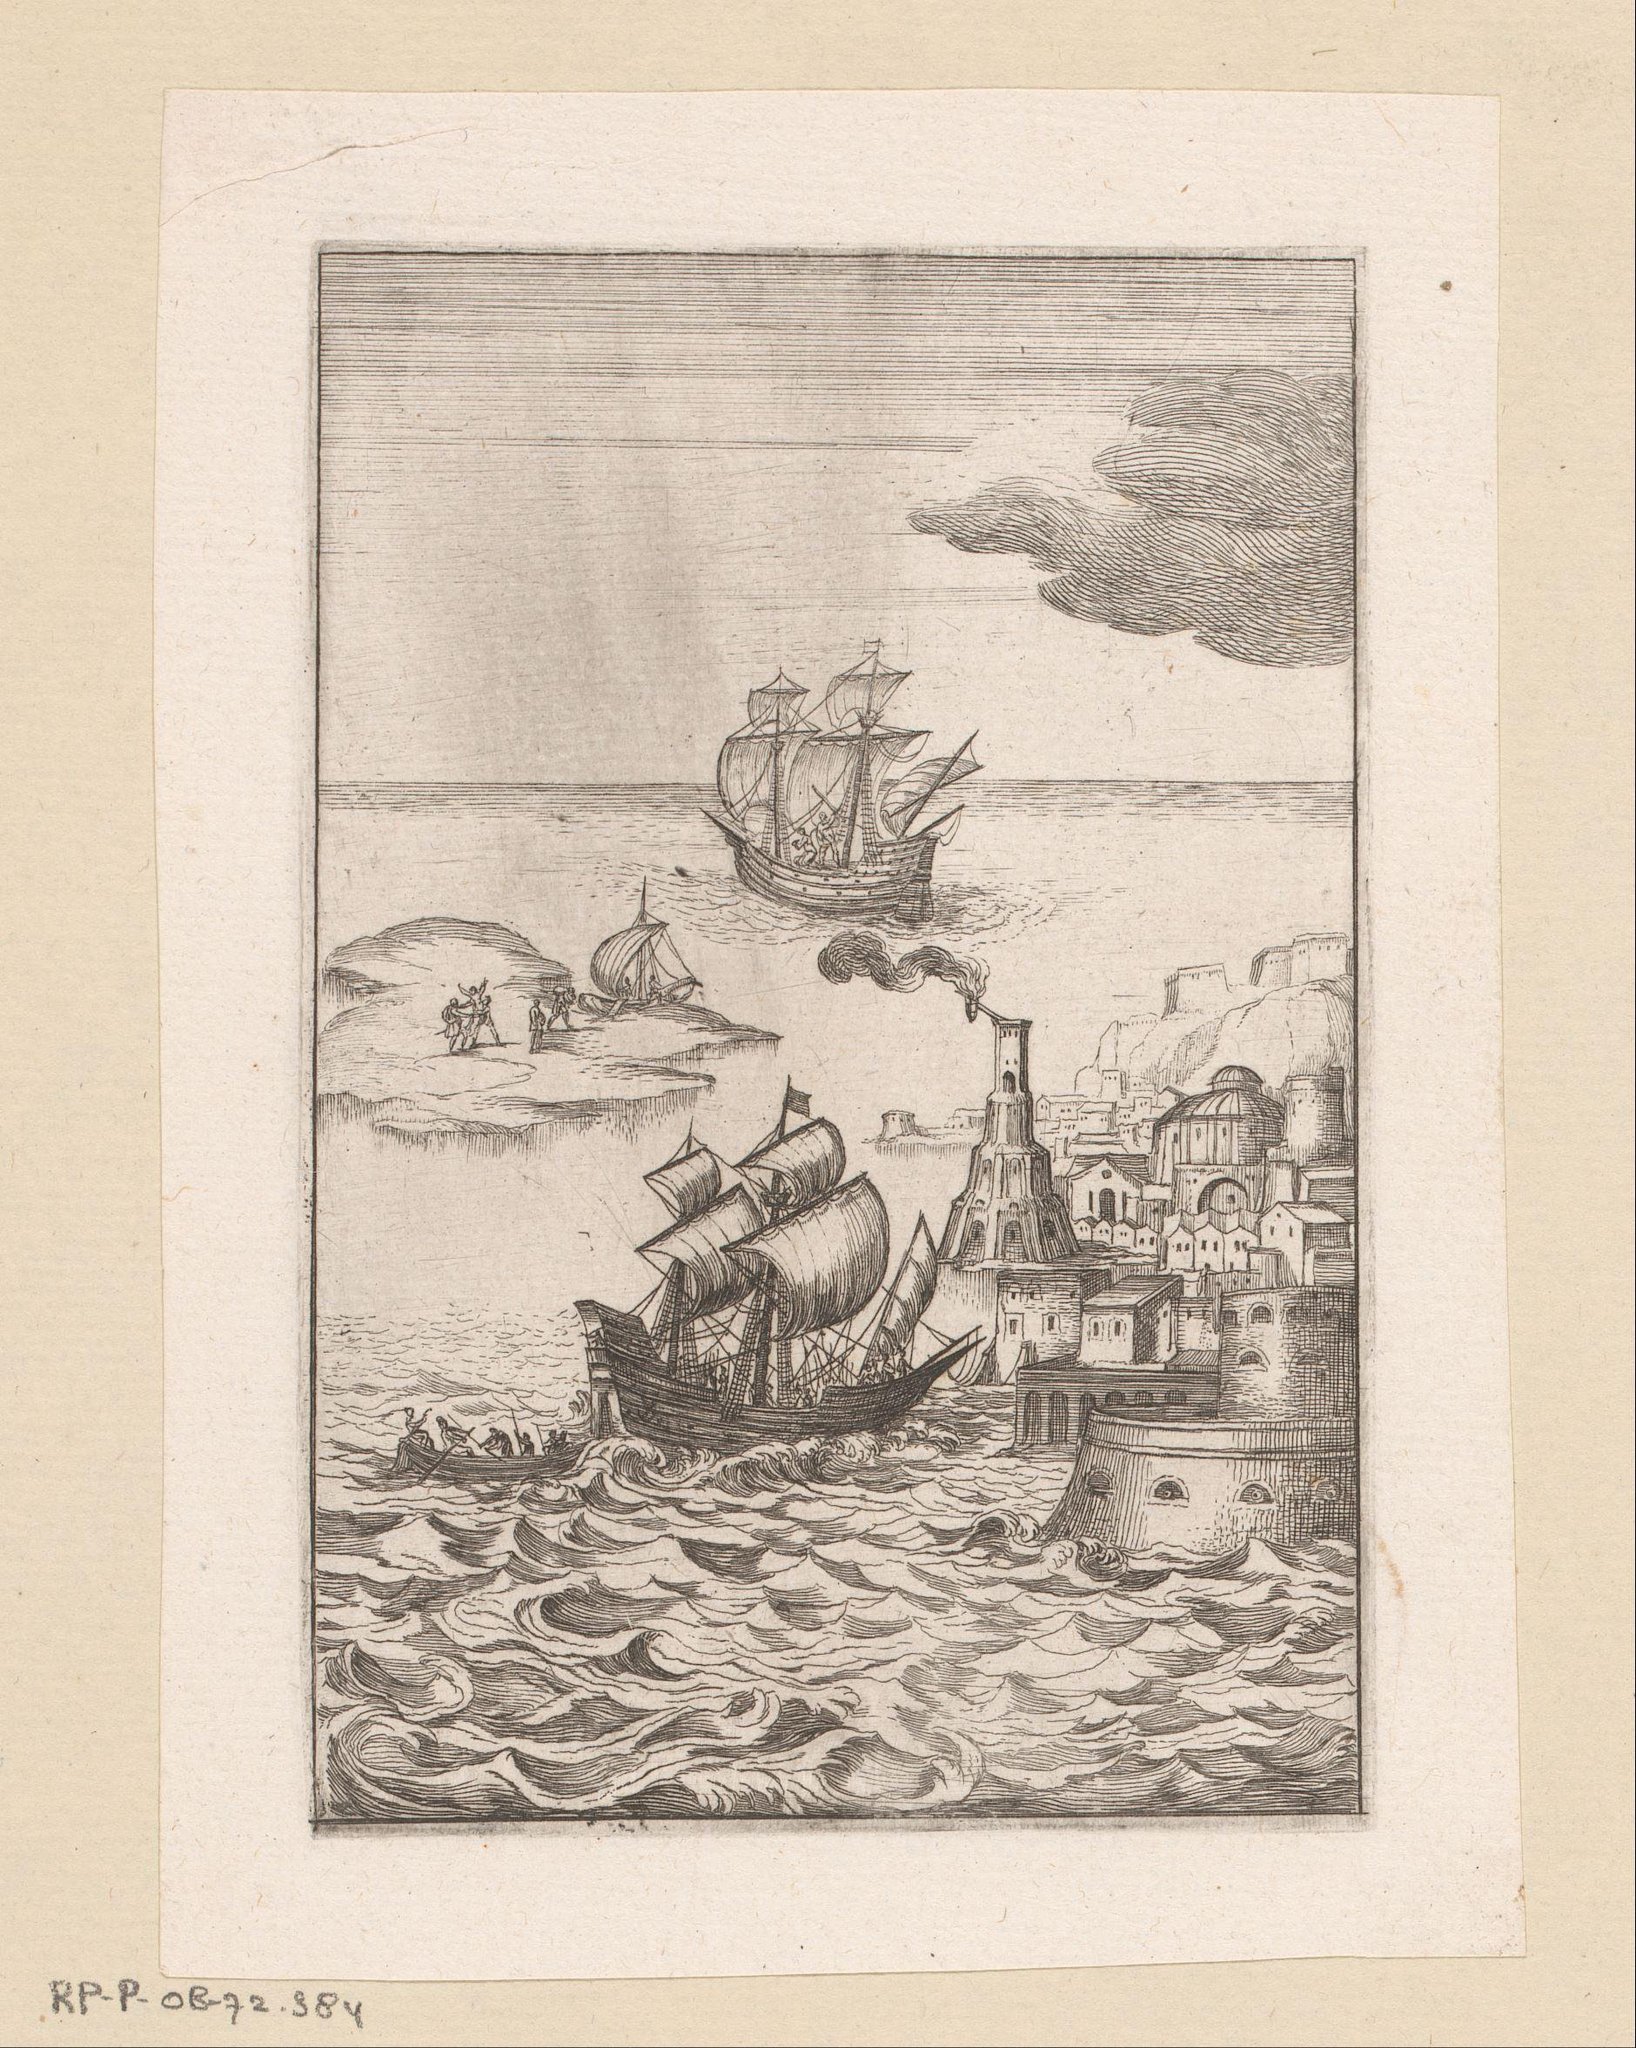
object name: print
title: Zeegezicht met een eiland, schepen en een stad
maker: daniel rabel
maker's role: print maker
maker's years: 1578-1637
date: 1588-1637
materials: paper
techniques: etching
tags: island, ships (in general) - cc - more than one ship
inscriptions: collector's mark: Lugt 240